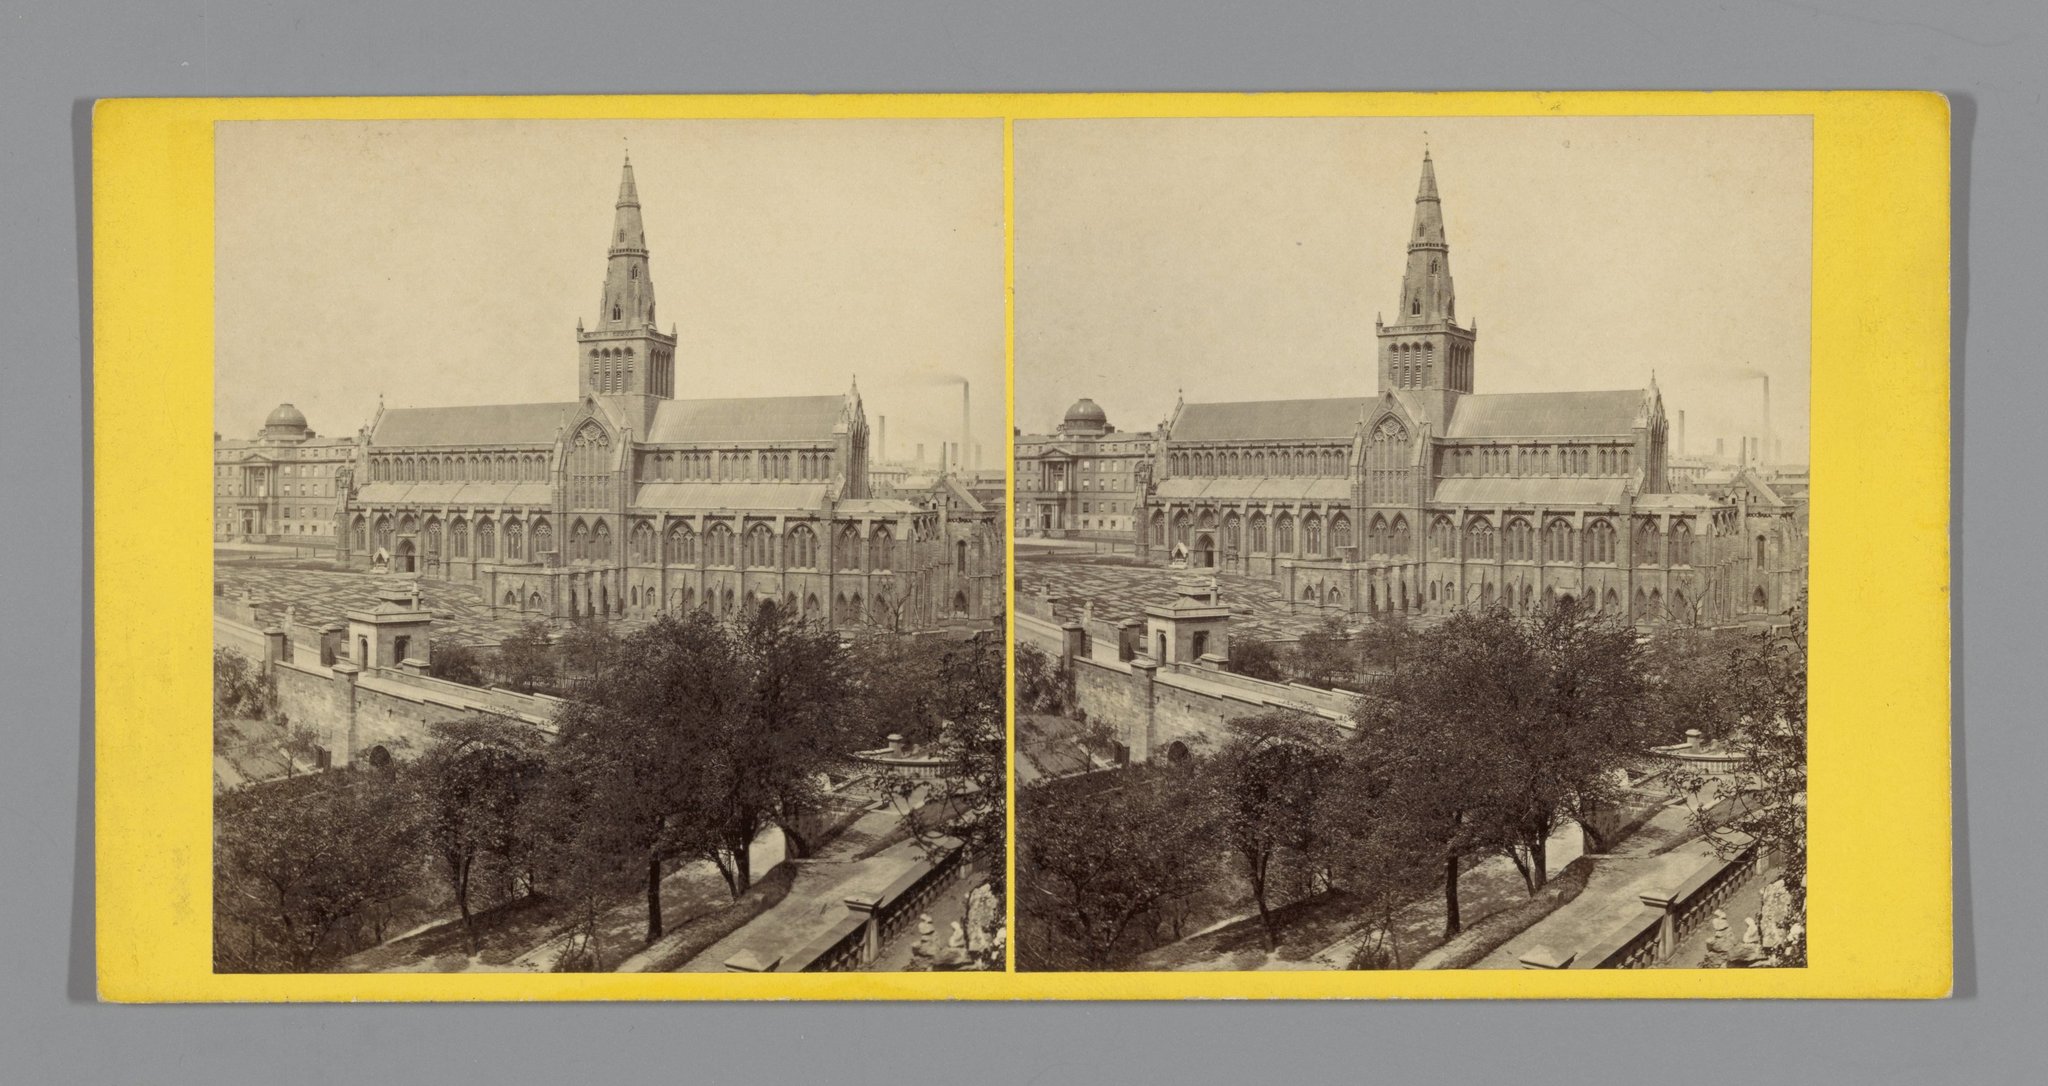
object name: stereograph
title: Glasgow Cathedral, from the South-East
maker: george washington wilson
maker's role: publisher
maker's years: 1823-1893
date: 1850-1880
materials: cardboard, photographic support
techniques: albumen print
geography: glasgow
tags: church (exterior)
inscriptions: number: ‘No. 38.’, name: ‘Registered G. W. Wilson, Photographer, Aberdeen’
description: Het object RP-F-F04793 is waarschijnlijk gemaakt tijdens dezelfde fotografeersessie.